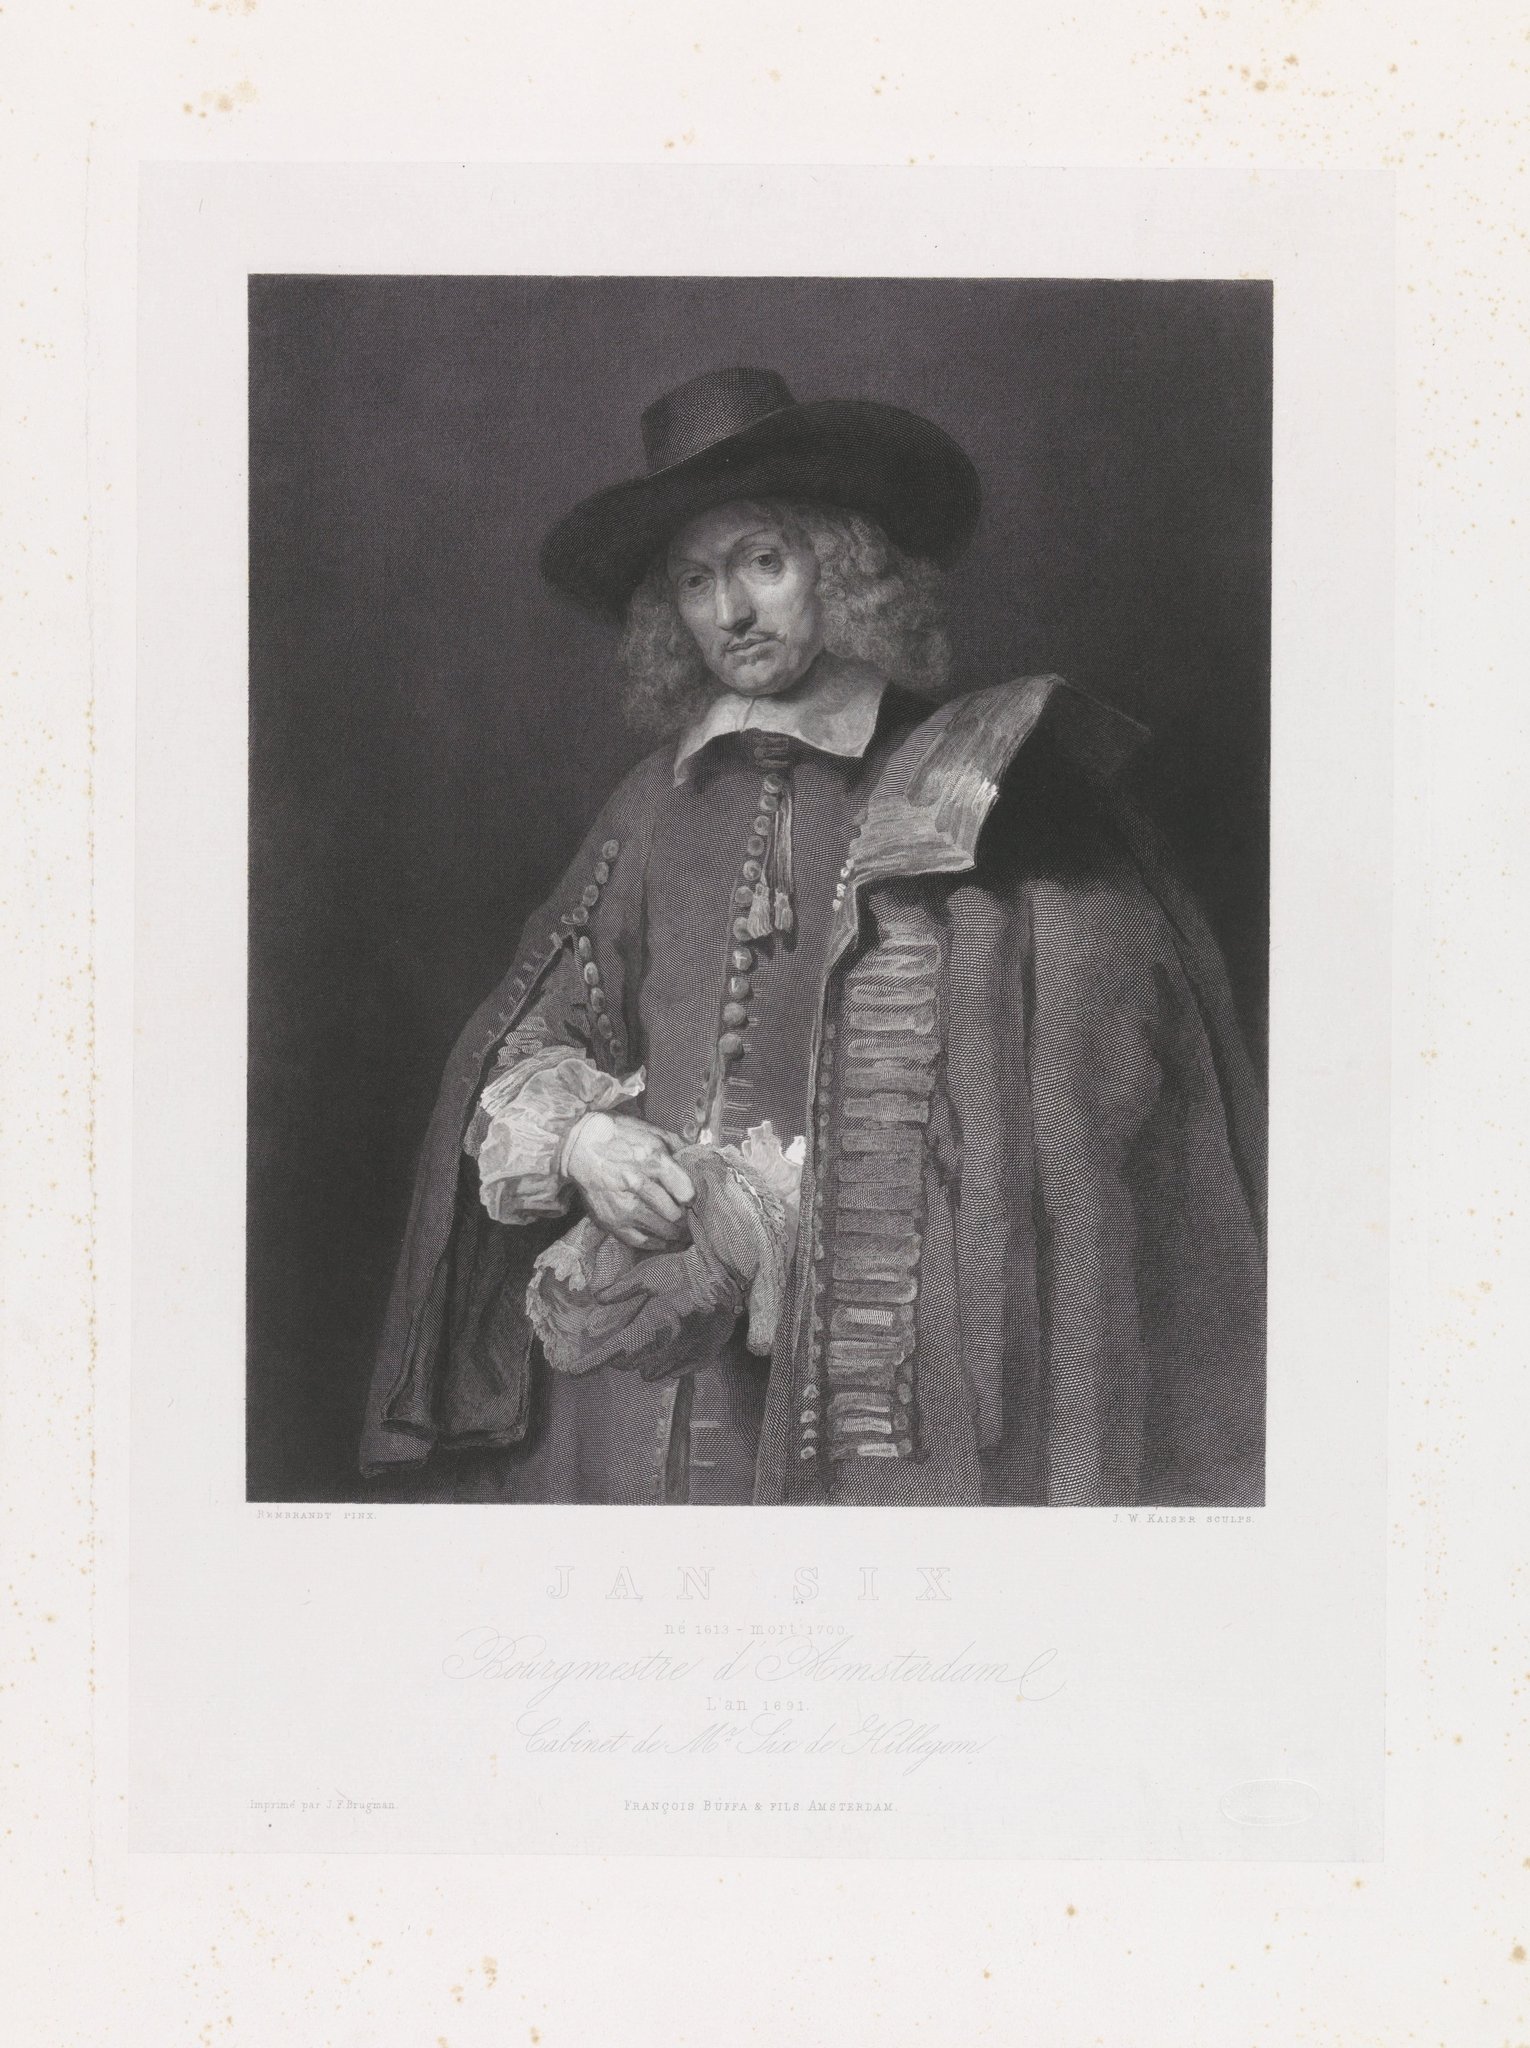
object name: print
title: Portret van Jan Six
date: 1823-1853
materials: paper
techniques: engraving, etching, roulette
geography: amsterdam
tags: amsterdam, mayor, jan six (1618-1700)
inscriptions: collector's mark: ‘François Buffa & Fils Amsterdam’, collector's mark: Lugt 2228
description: Portret ten halven lijve van Jan Six, burgemeester van Amsterdam.